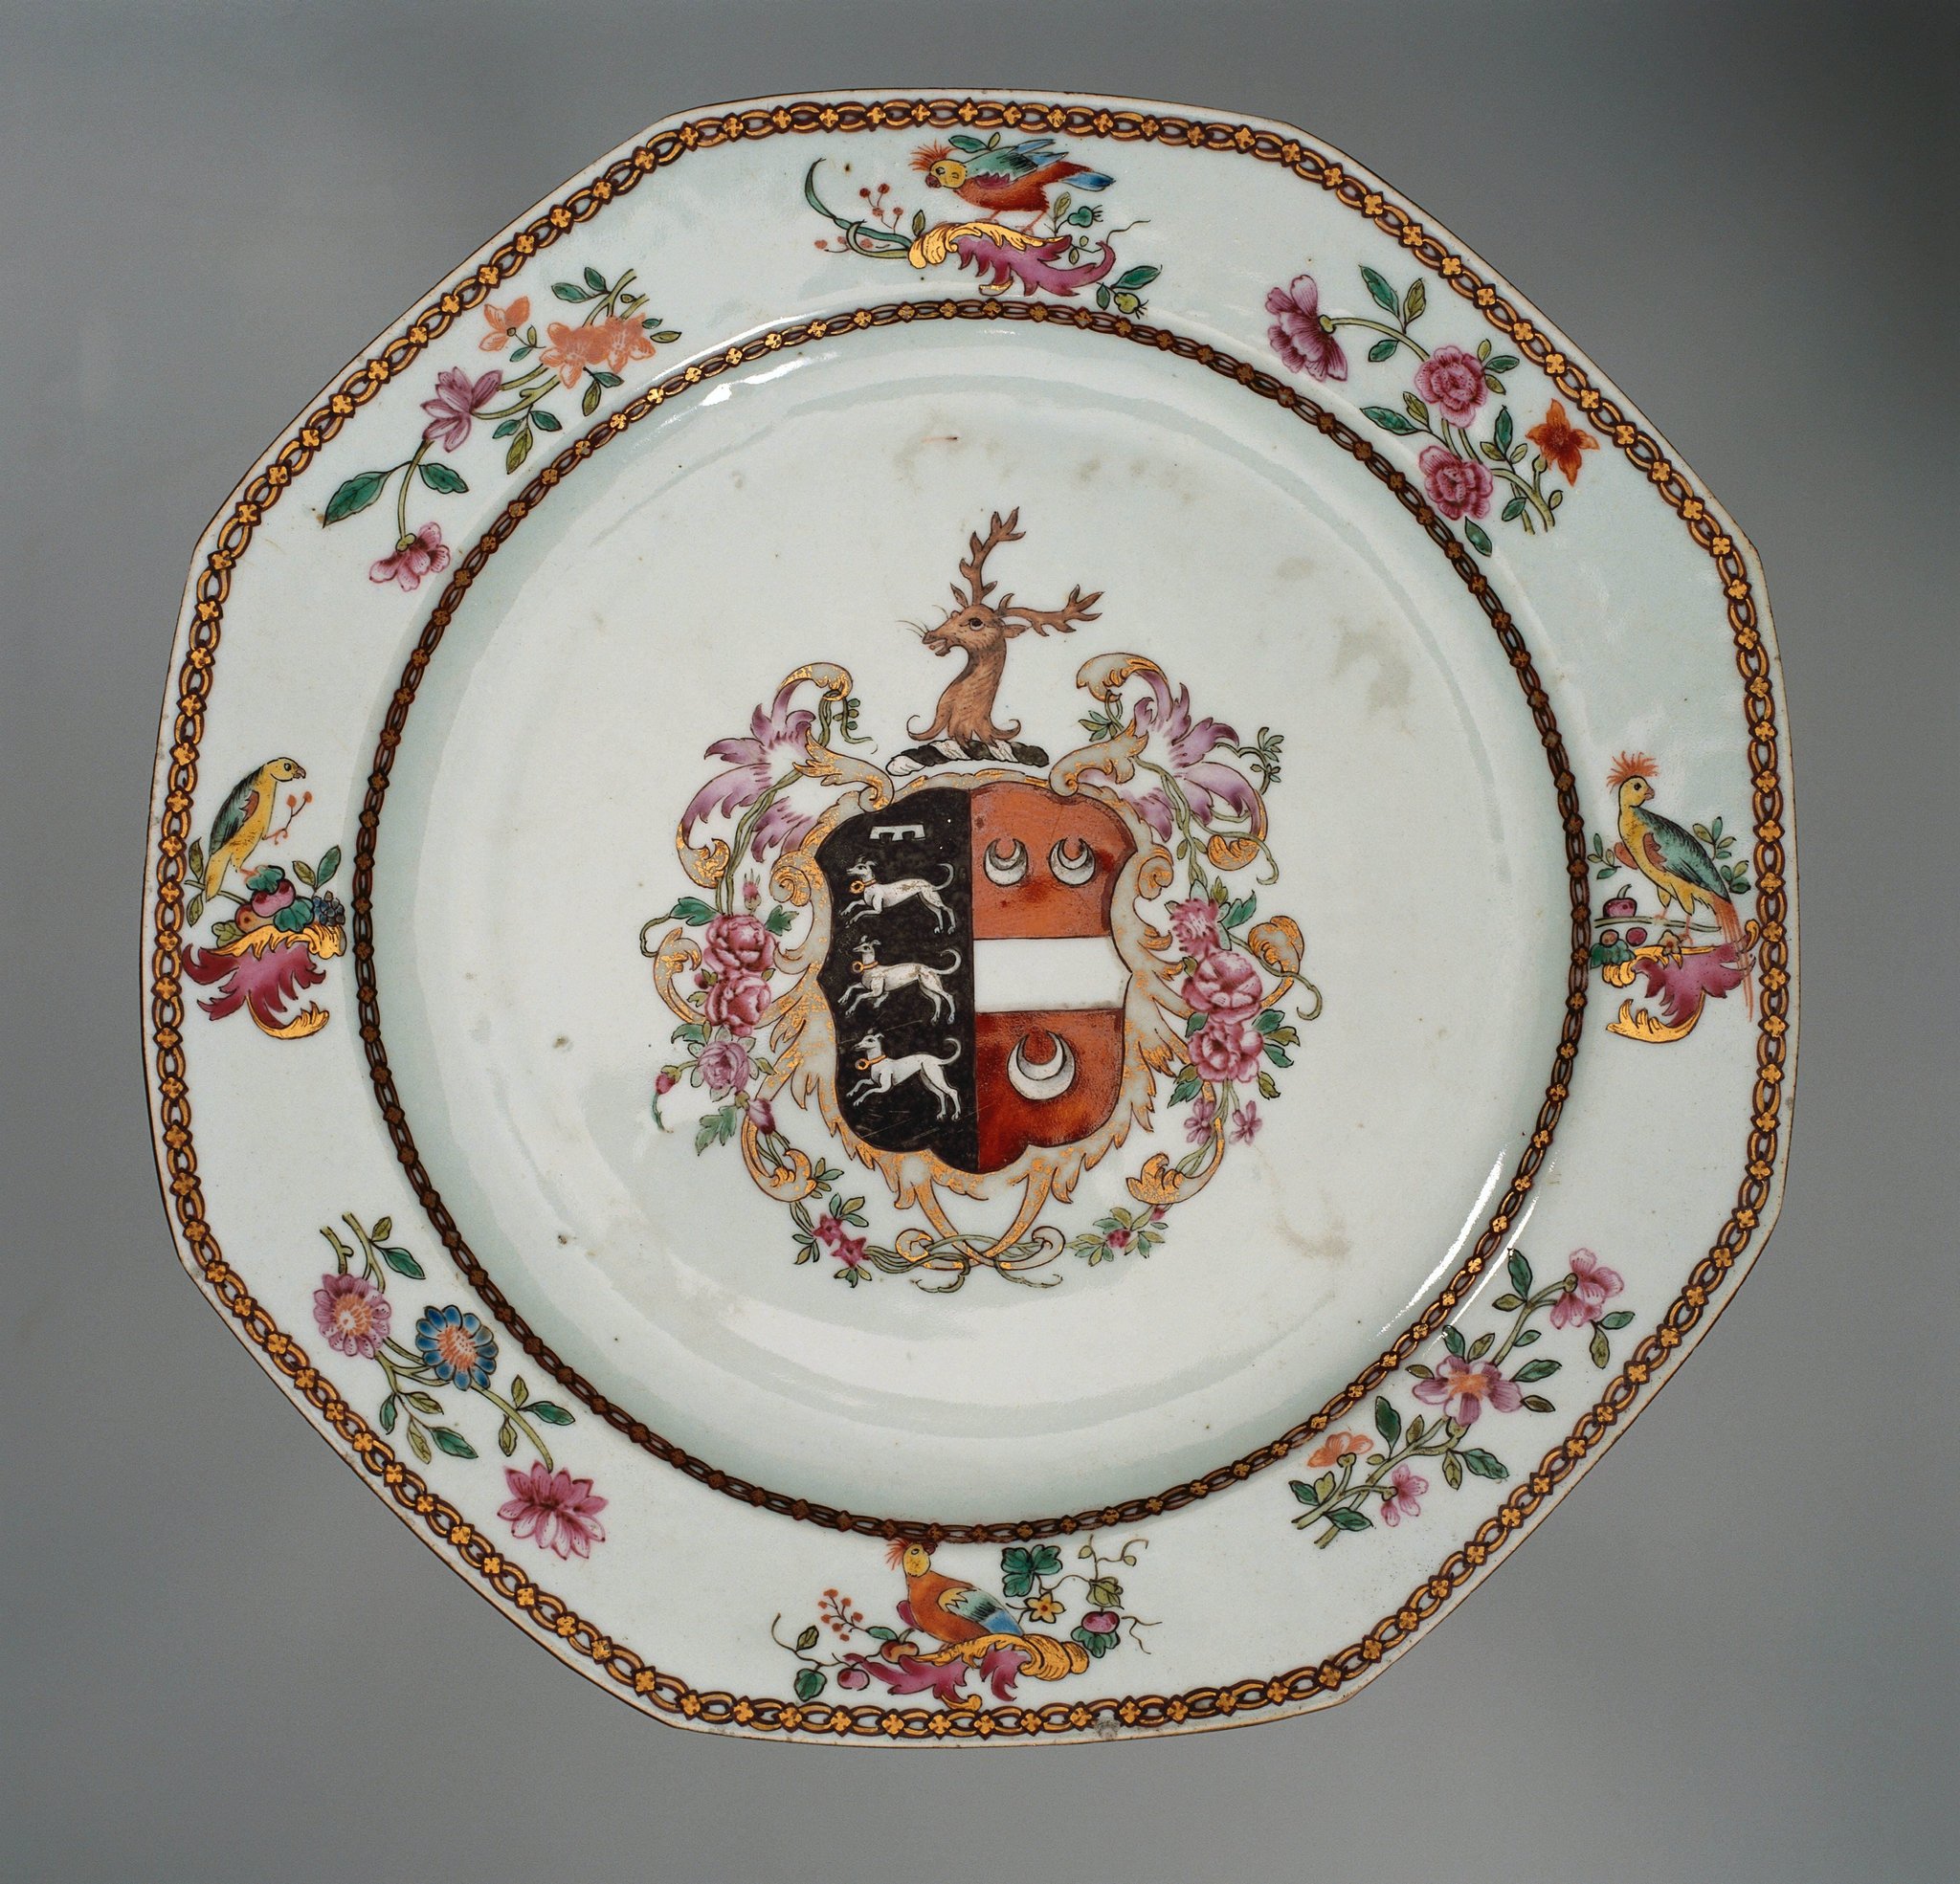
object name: plate dish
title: Octagonal plate with the arms of the Machell and Holloway family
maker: Anonymous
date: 1750-1774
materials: glaze, gold, paint, porcelain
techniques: firing, forming, gilding, turning, vitrification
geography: china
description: Achthoekig bord van porselein, berschilderd op het glazuur in blauw, rood, roze, groen, geel, zwart en goud. Op het plat het wapen van de families Machell en Holloway omgeven door bloemranken. Het helmteken is een hertenkop. Op de wand een band met schakelmotief; de rand met bloemtakken, vogels op een bladrank en een schakelmotief. Wapenporselein met emailkleuren.